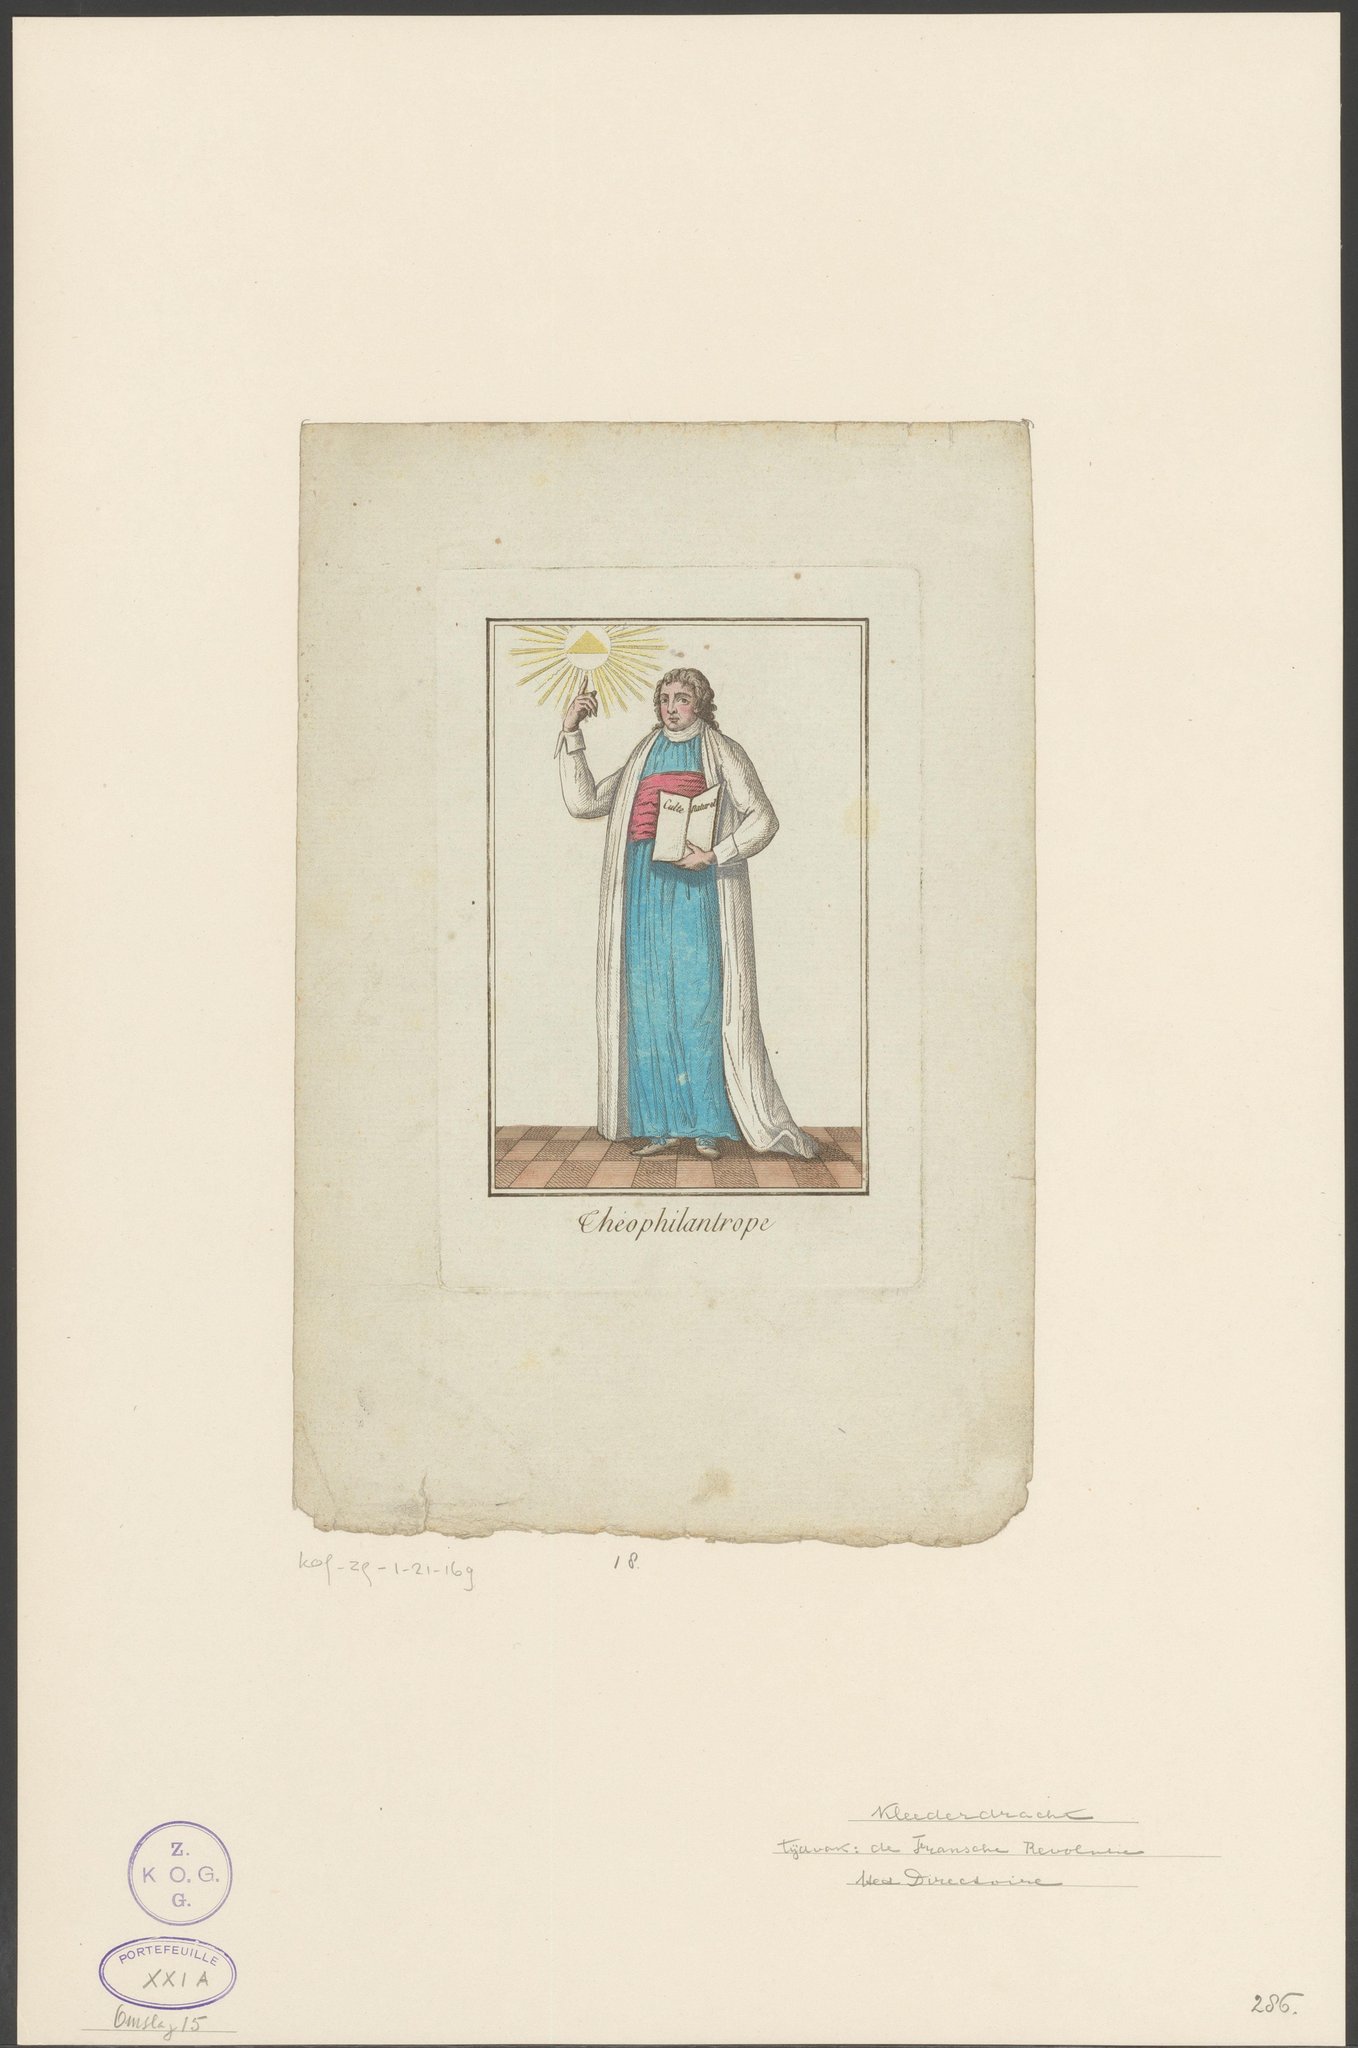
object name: print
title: Kostuums van de leden van twee raden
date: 1795-1799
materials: paper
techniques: etching, hand coloring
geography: paris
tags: star forms ~ magic mathematical figures, book - mm - book open, christian religion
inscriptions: stamp, collector's mark: Lugt 1641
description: Onder zijn arm een boek met de tekst: Culte Natural. Onderwerpsrubrieken binnen de Atlas Zeden en Gewoonten: Zeden en Gewoonten in Engeren Zin, De Kleeding, Kleederdrachten (tijdvakken), De Fransche Revolutie. (Het Directoire).